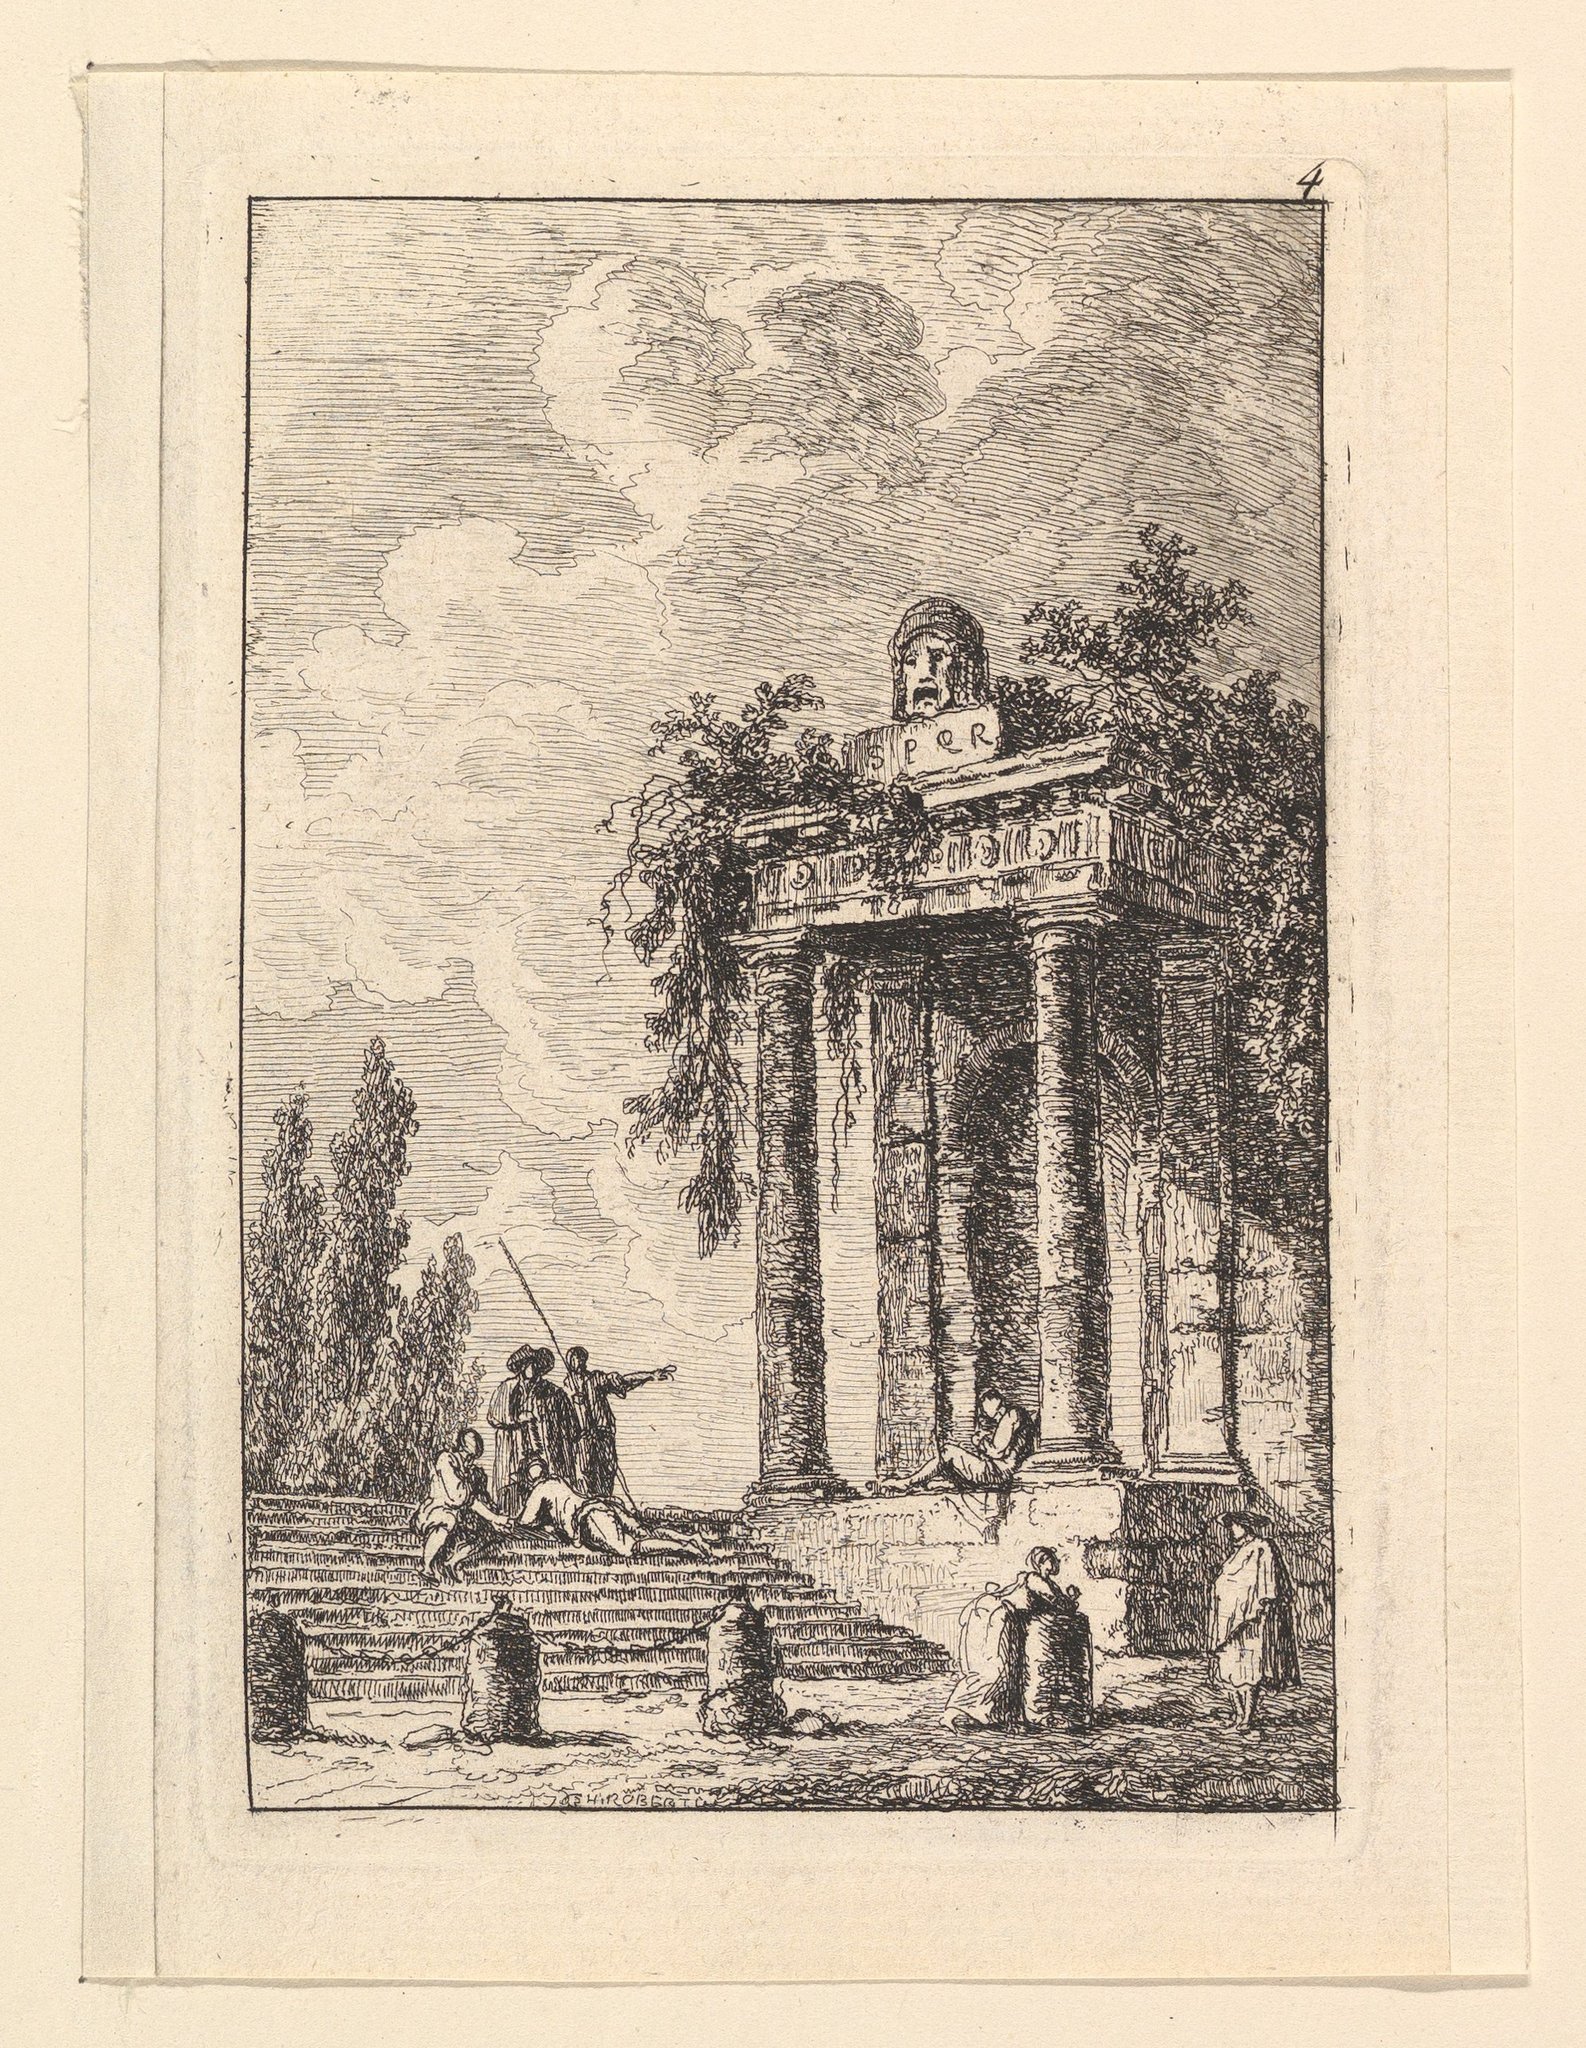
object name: print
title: L'Escalier aux Quatre Bornes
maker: hubert robert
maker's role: artist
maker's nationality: french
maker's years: 1733-1808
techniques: etching